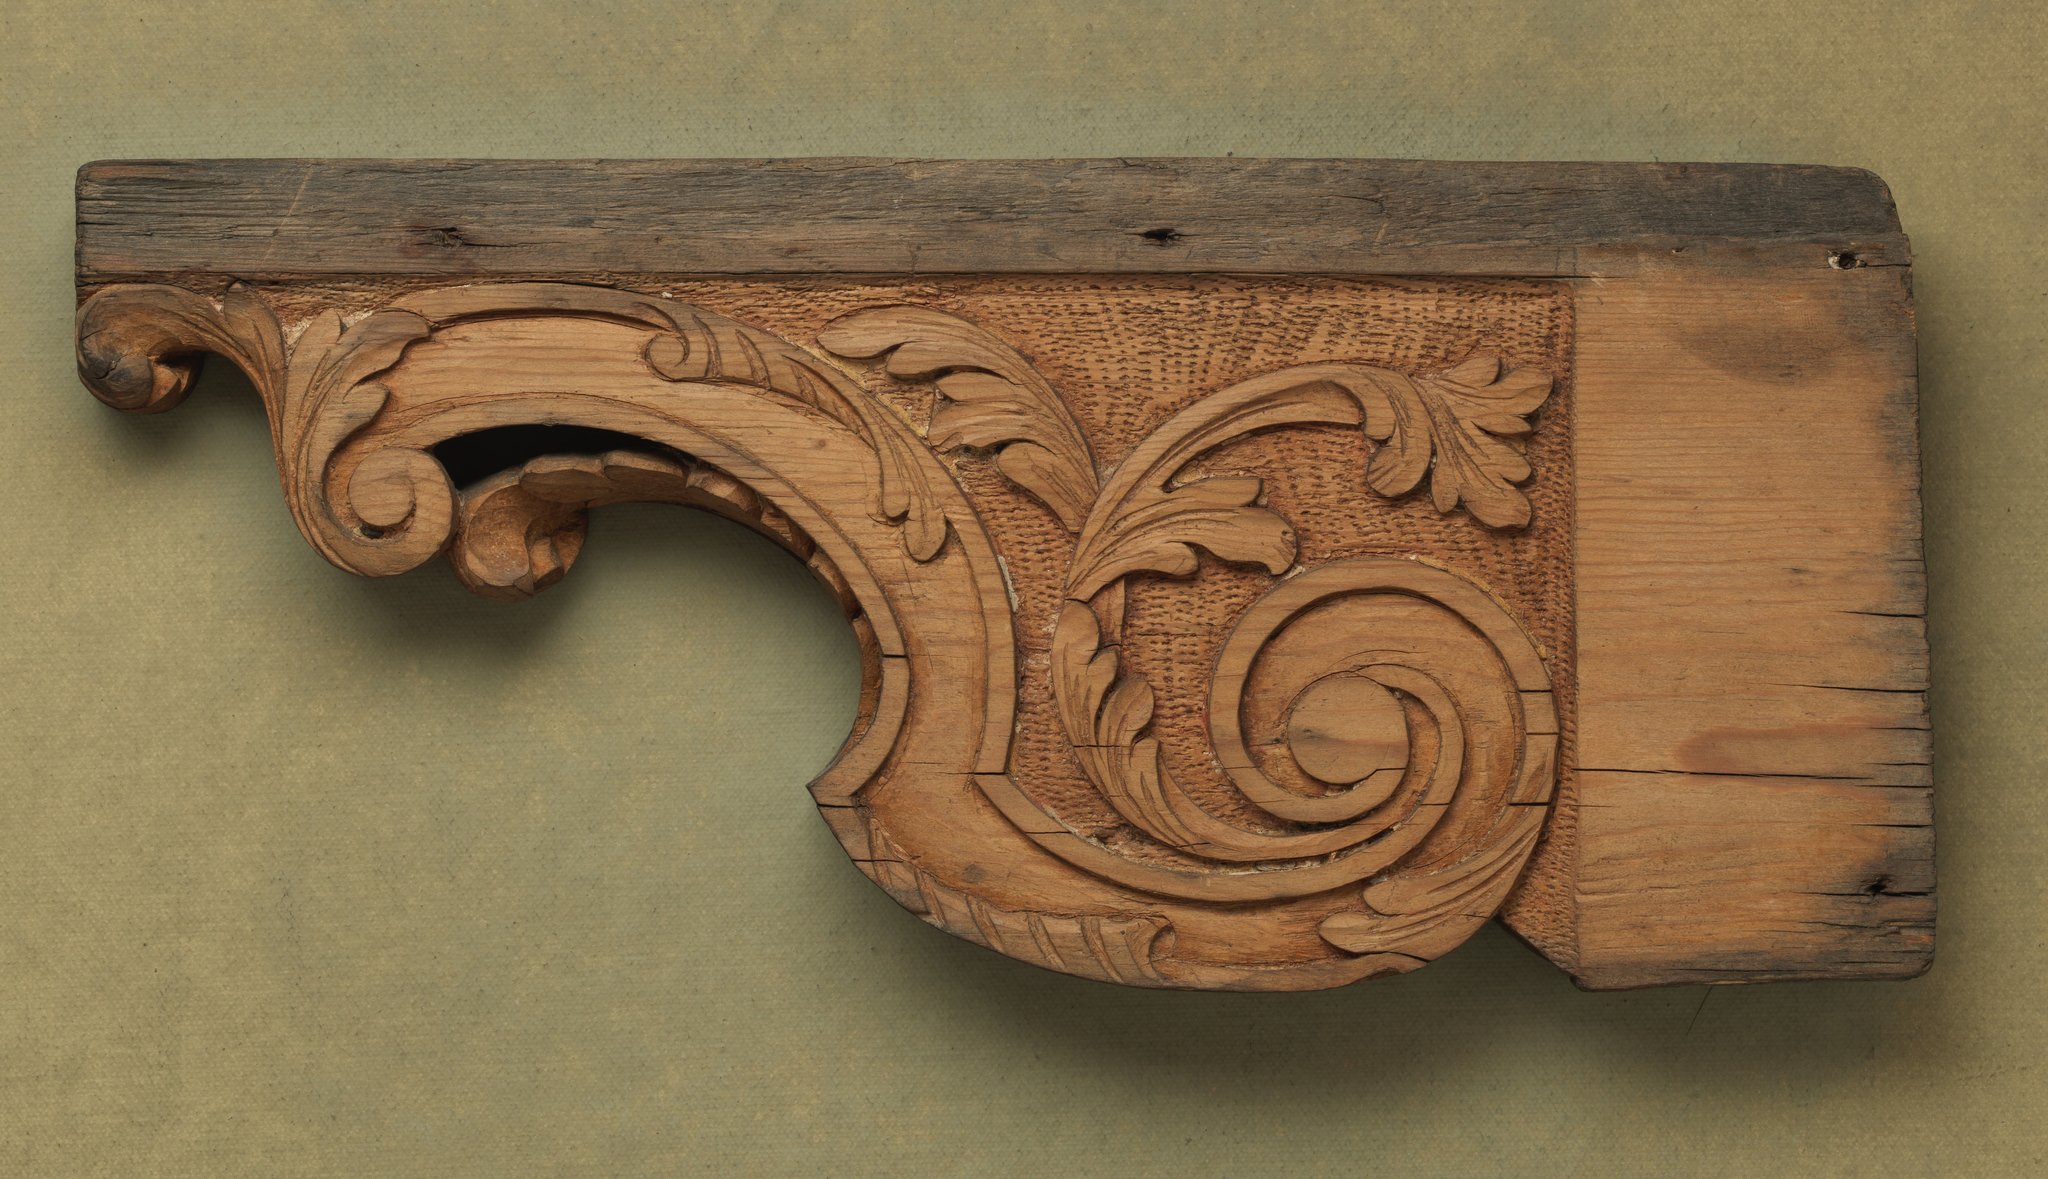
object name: bracket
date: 1701-1800